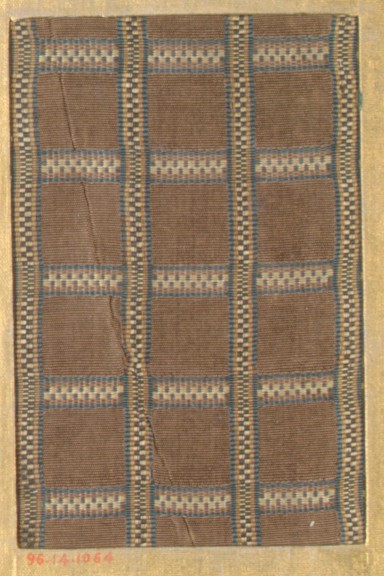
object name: piece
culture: japanese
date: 1701-1900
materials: silk